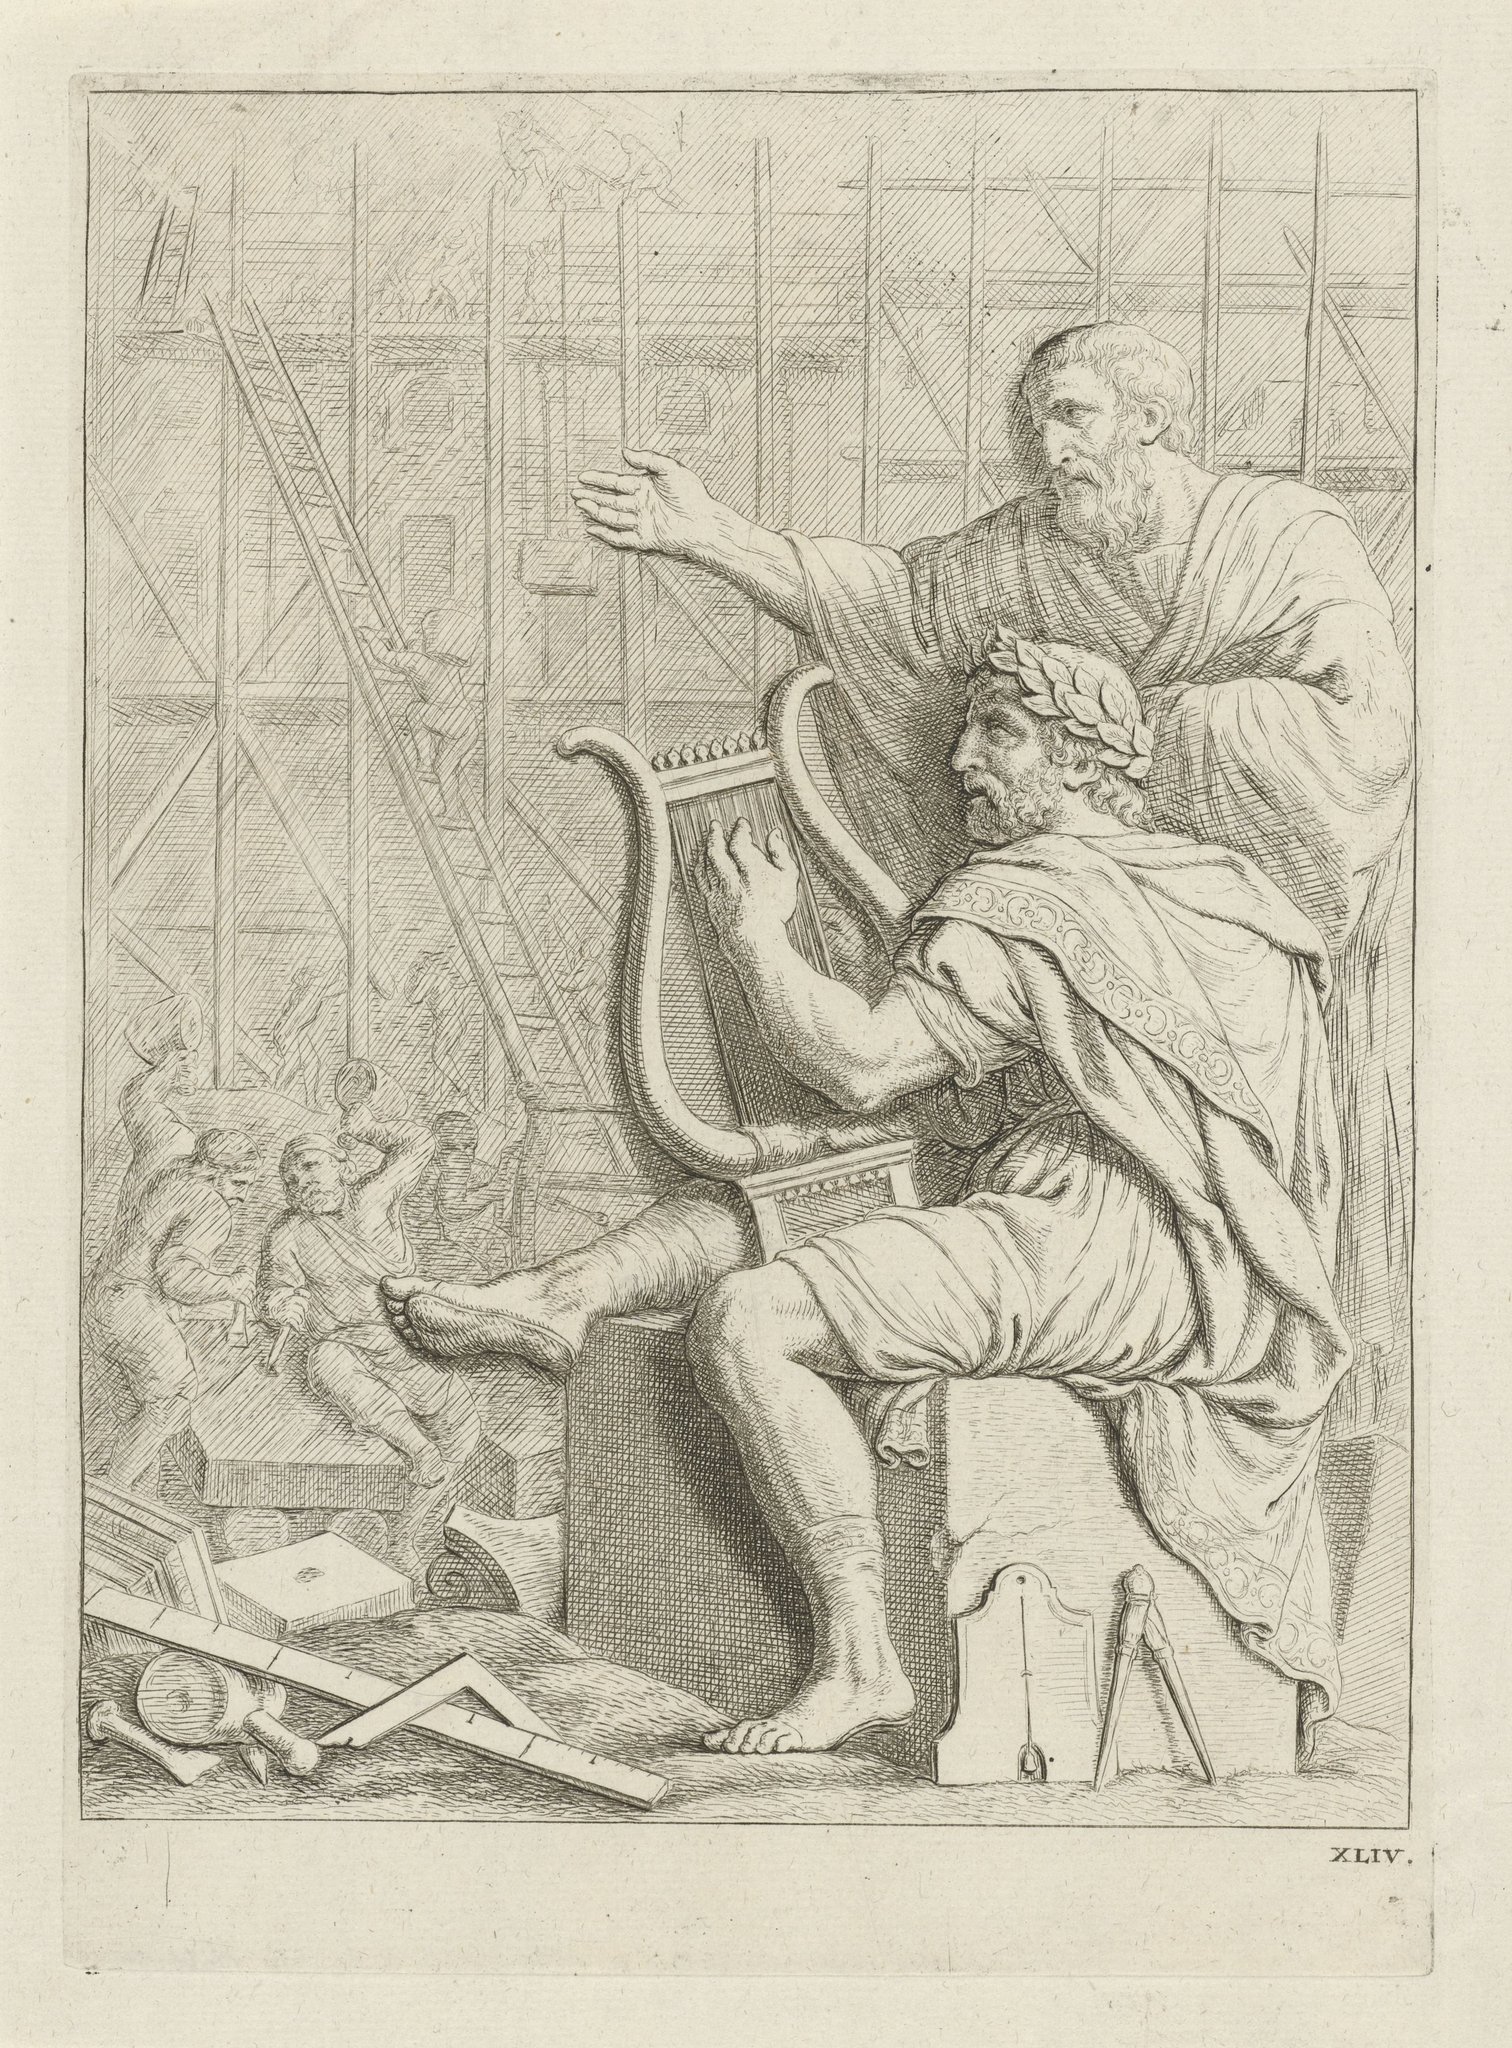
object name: book illustration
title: Reliëf met Amphion en Zethos in de Burgerzaal van het Stadhuis op de Dam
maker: hubert quellinus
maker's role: print maker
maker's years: 1619-1687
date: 1663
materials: paper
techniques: engraving, etching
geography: amsterdam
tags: amphion building the walls of thebes (without zethus), measuring-instruments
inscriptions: collector's mark: Lugt 2228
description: Huidige staat van prent ook gebruikt in: Architecture peinture et sculpture de la Maison de Ville d'Amsterdam, representee en CIX. figures en taille-douce (…). Amsterdam: David Mortier, 1719. En in: Architecture peinture et sculpture de la Maison de Ville d'Amsterdam, representee en CIX. figures en taille-douce (…). Amsterdam: Gerard Valck, 1719. En in: Bouw schilder en beeldhouwkonst, van het Stadhuis te Amsteldam, vertoont in CIX figuuren (…). Amsterdam: Covens & Mortier & Covens Jr., s.a. (1774-1783). Eerdere staat van prent ook gebruikt in: Secunca pars Praecipuarum effigierum ac ornamentorum amplissime Curiae Amstelrodamensis maiori ex parte in cadido marmore effectorum per Artum Quellinium eiusdem Civitatis Statuarium / Het tweede deel Van de voornaemste Statuen ende Cieraten van 't konst-rijcke Stadt-huys van Amstelredam 'tmeeste in Marmer gemaeckt door Artus Quellinus Beelthouwer der voorseyde Stadt. Amsterdam: Artus Quellinus (I), 1663. En in: Secunca pars Praecipuarum effigierum ac ornamentorum amplissime Curiae Amstelrodamensis maiori ex parte in cadido marmore effectorum per Artum Quellinium eiusdem Civitatis Statuarium / Het tweede deel Van de voornaemste Statuen ende Cieraten van 't konst-rijcke Stadt-huys van Amstelredam 'tmeeste in Marmer gemaeckt door Artus Quellinus Beelthouwer der voorseyde Stadt. Amsterdam: Frederik de Wit, 1668.